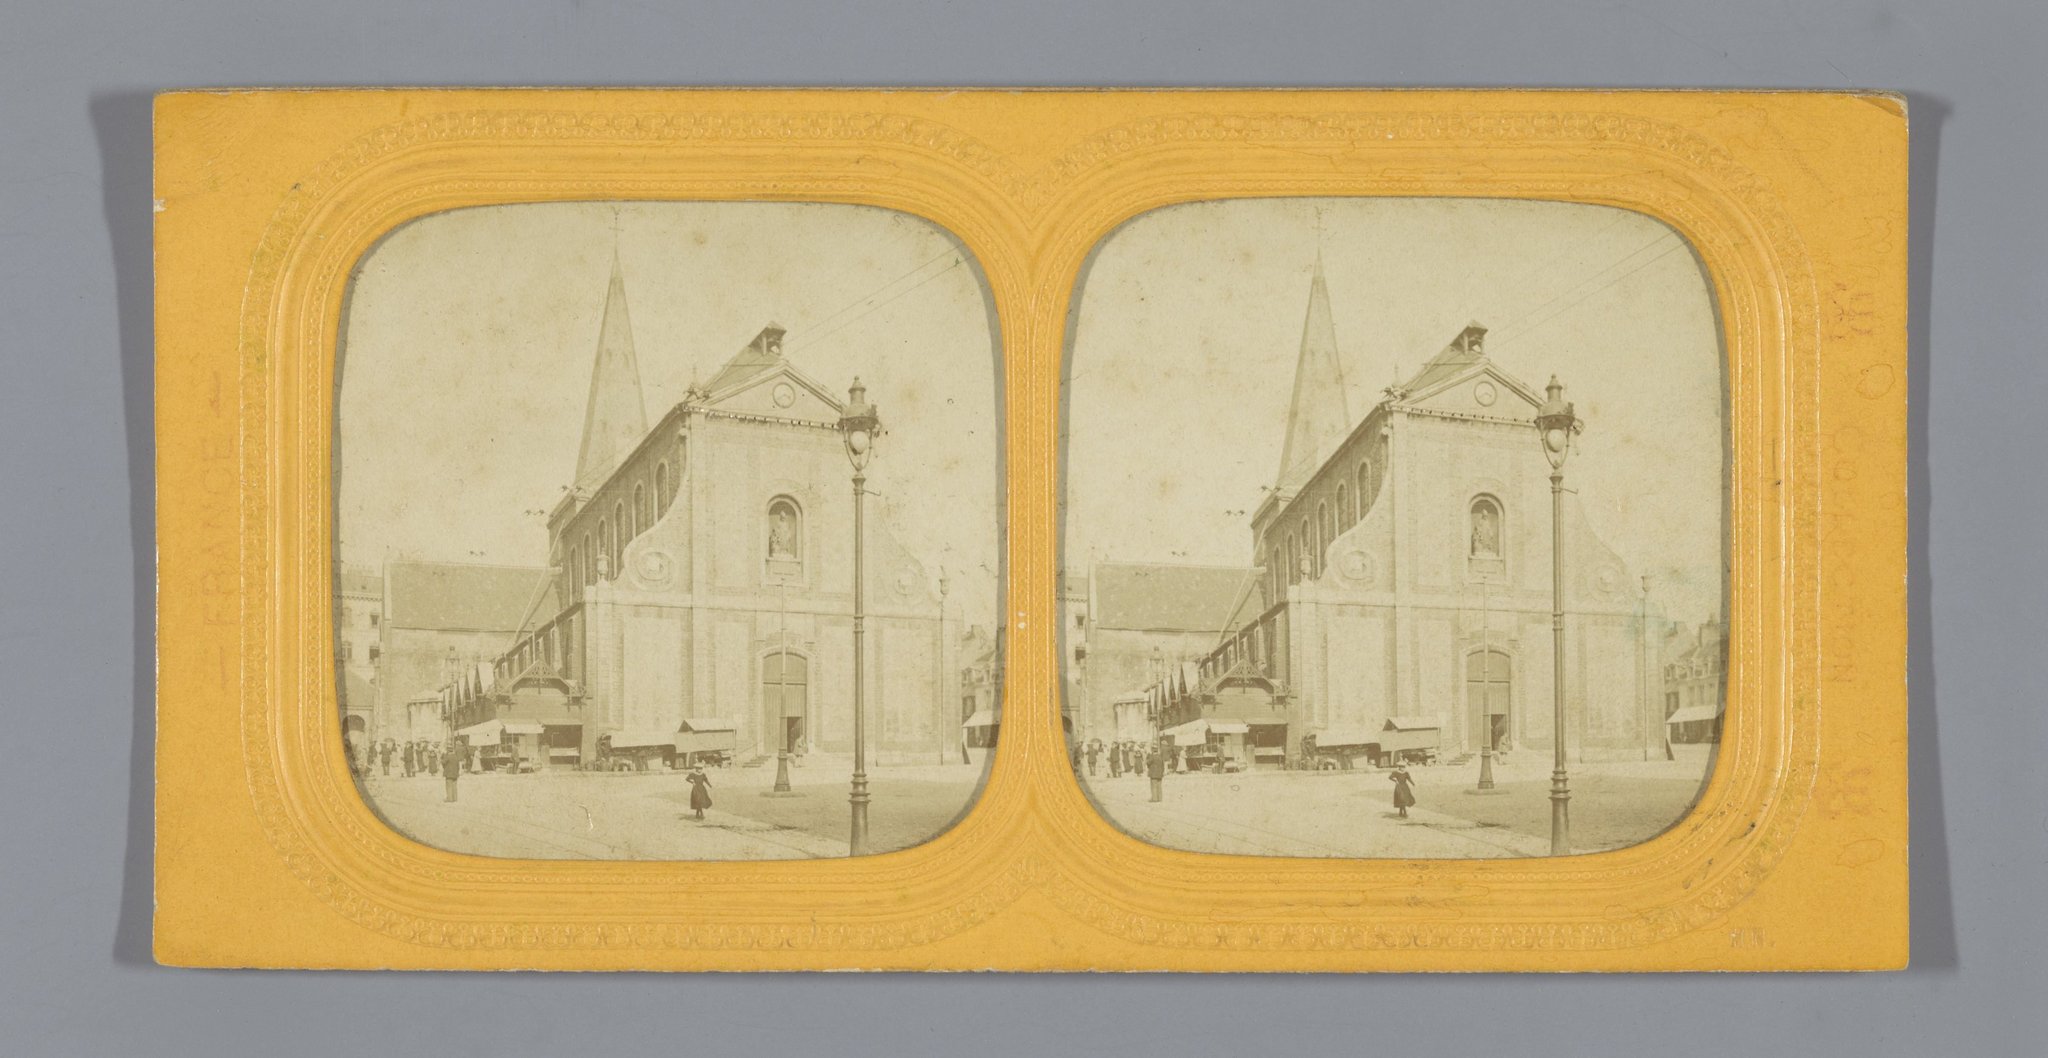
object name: tissue stereograph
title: Collection France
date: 1855-1875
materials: cardboard, paper, photographic support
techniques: albumen print, hand coloring, perforating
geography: paris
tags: church (exterior)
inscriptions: number: ‘25’, inscription: ‘HN’